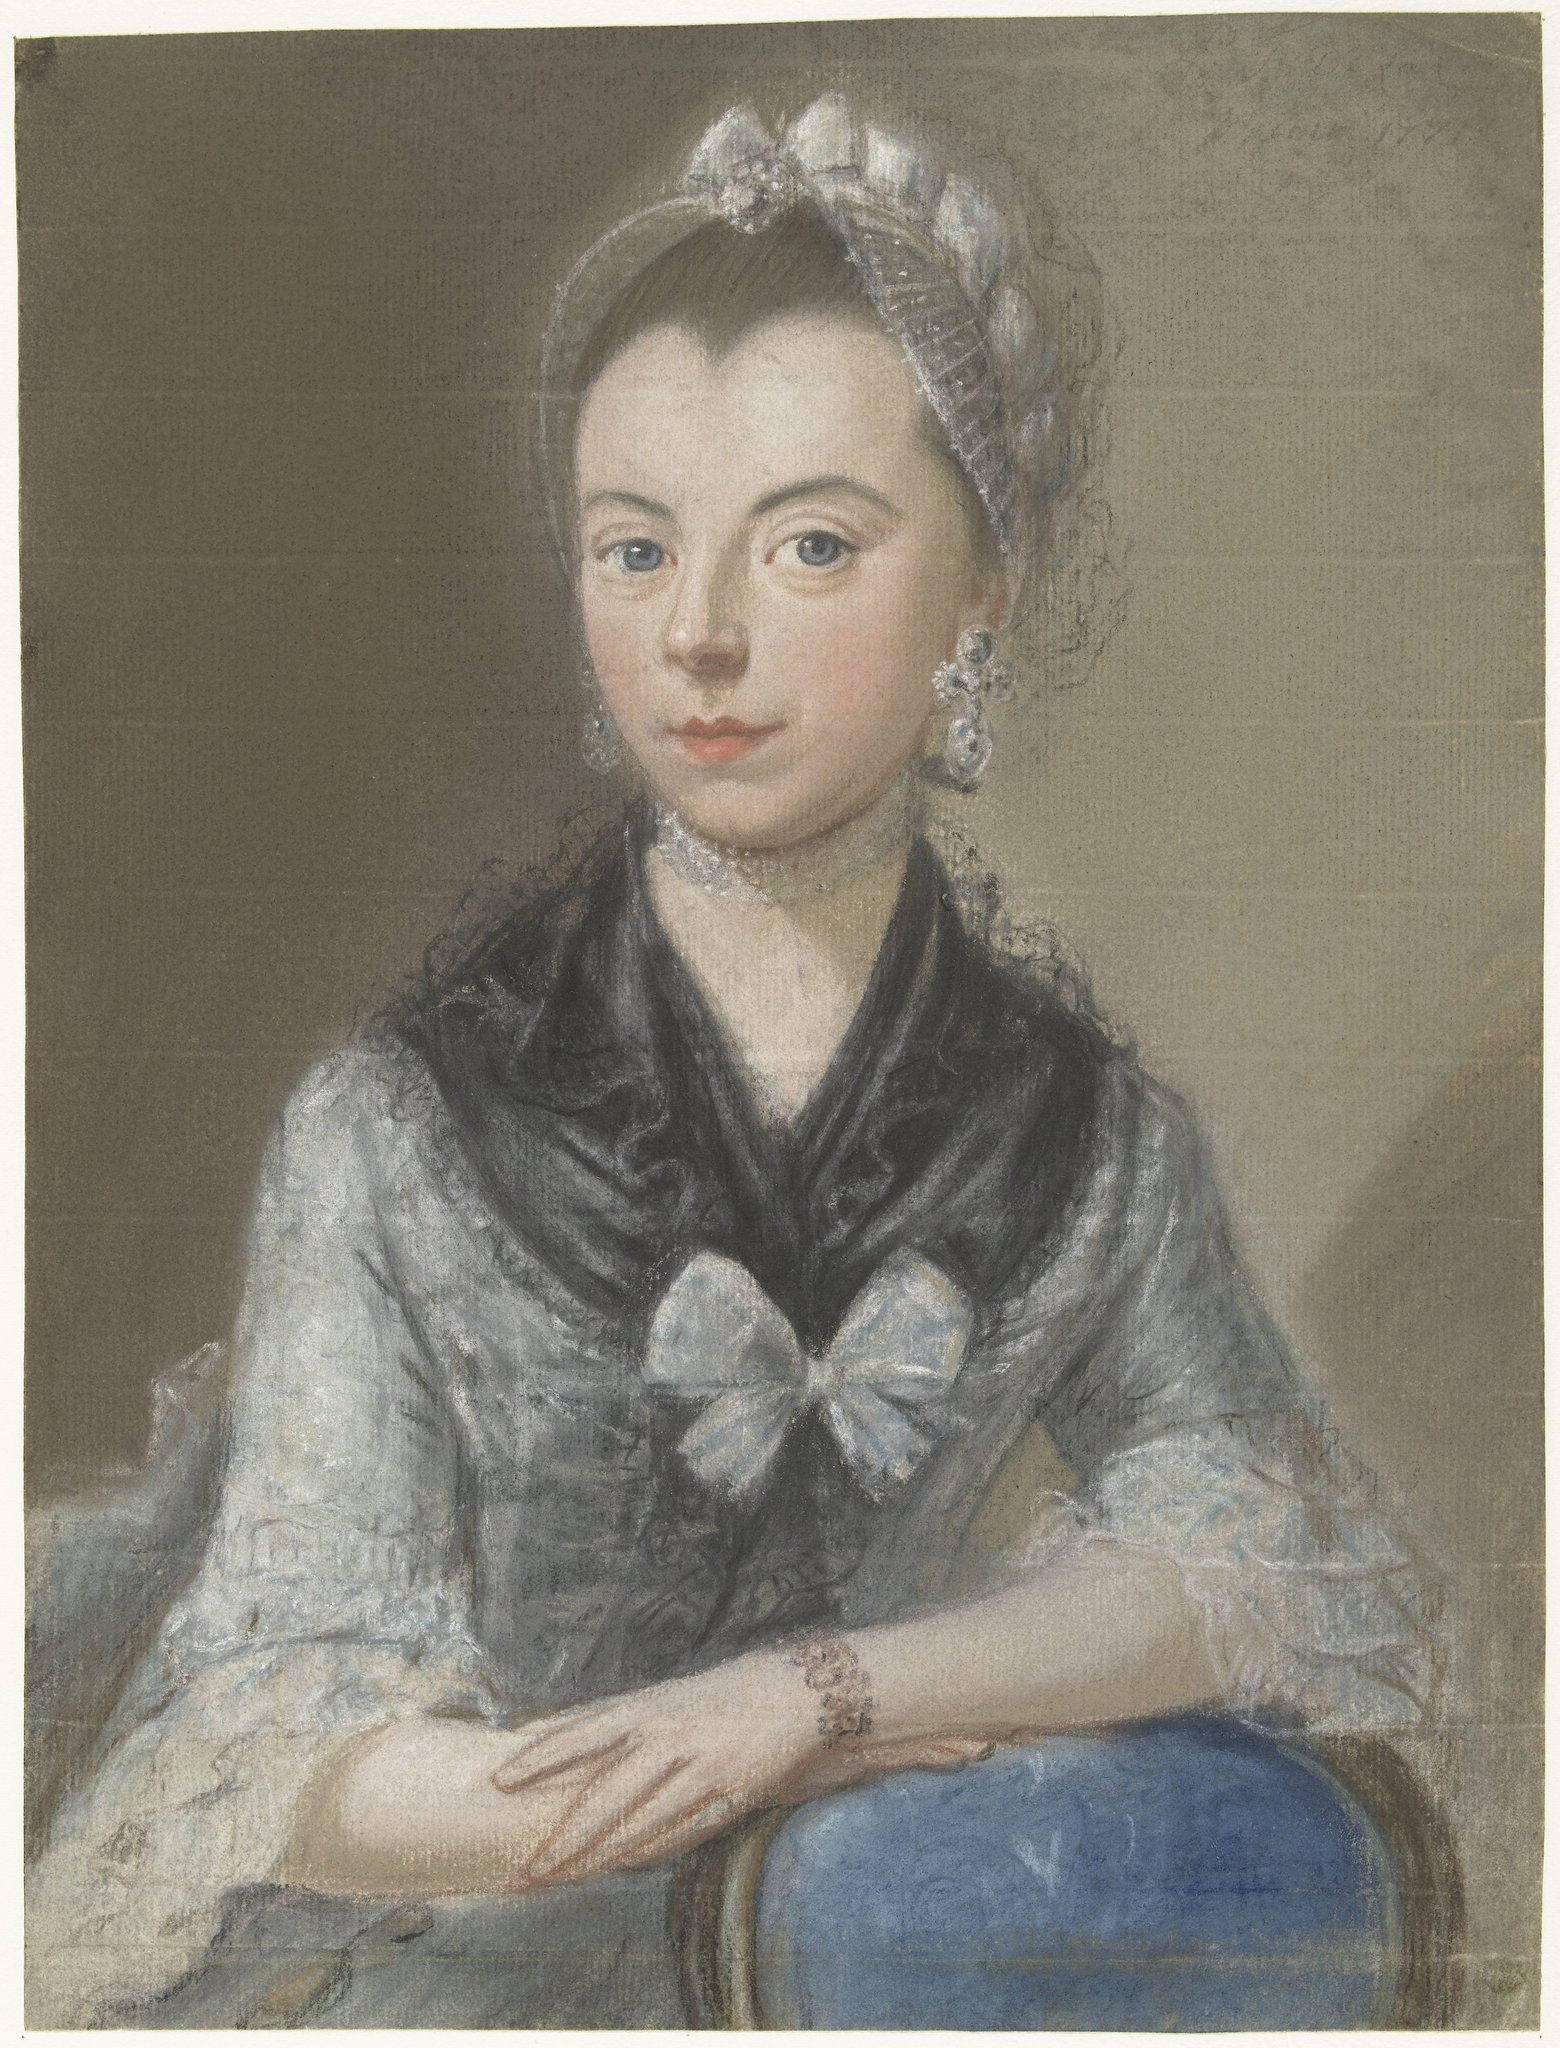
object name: drawing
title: Portrait of Susanna van Os-de la Croix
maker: pieter frederik de la croix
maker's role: draughtsman, painter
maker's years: 1709-1782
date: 1776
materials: paper, pastel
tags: historical persons - bb - woman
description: The French painter Pierre Frédéric de la Croix immortalized his daughter Susanna van Os-de la Croix in this chalk drawing. She is fashionably dressed and wears several pieces of jewellery. Along with an impressive pearl necklace, diamonds sparkle on her ears and in her hair. Her earrings resemble several of the designs on display.